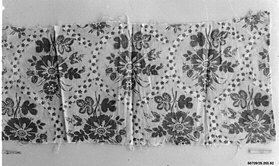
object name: floral print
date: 1775-1785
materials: cotton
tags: flowers